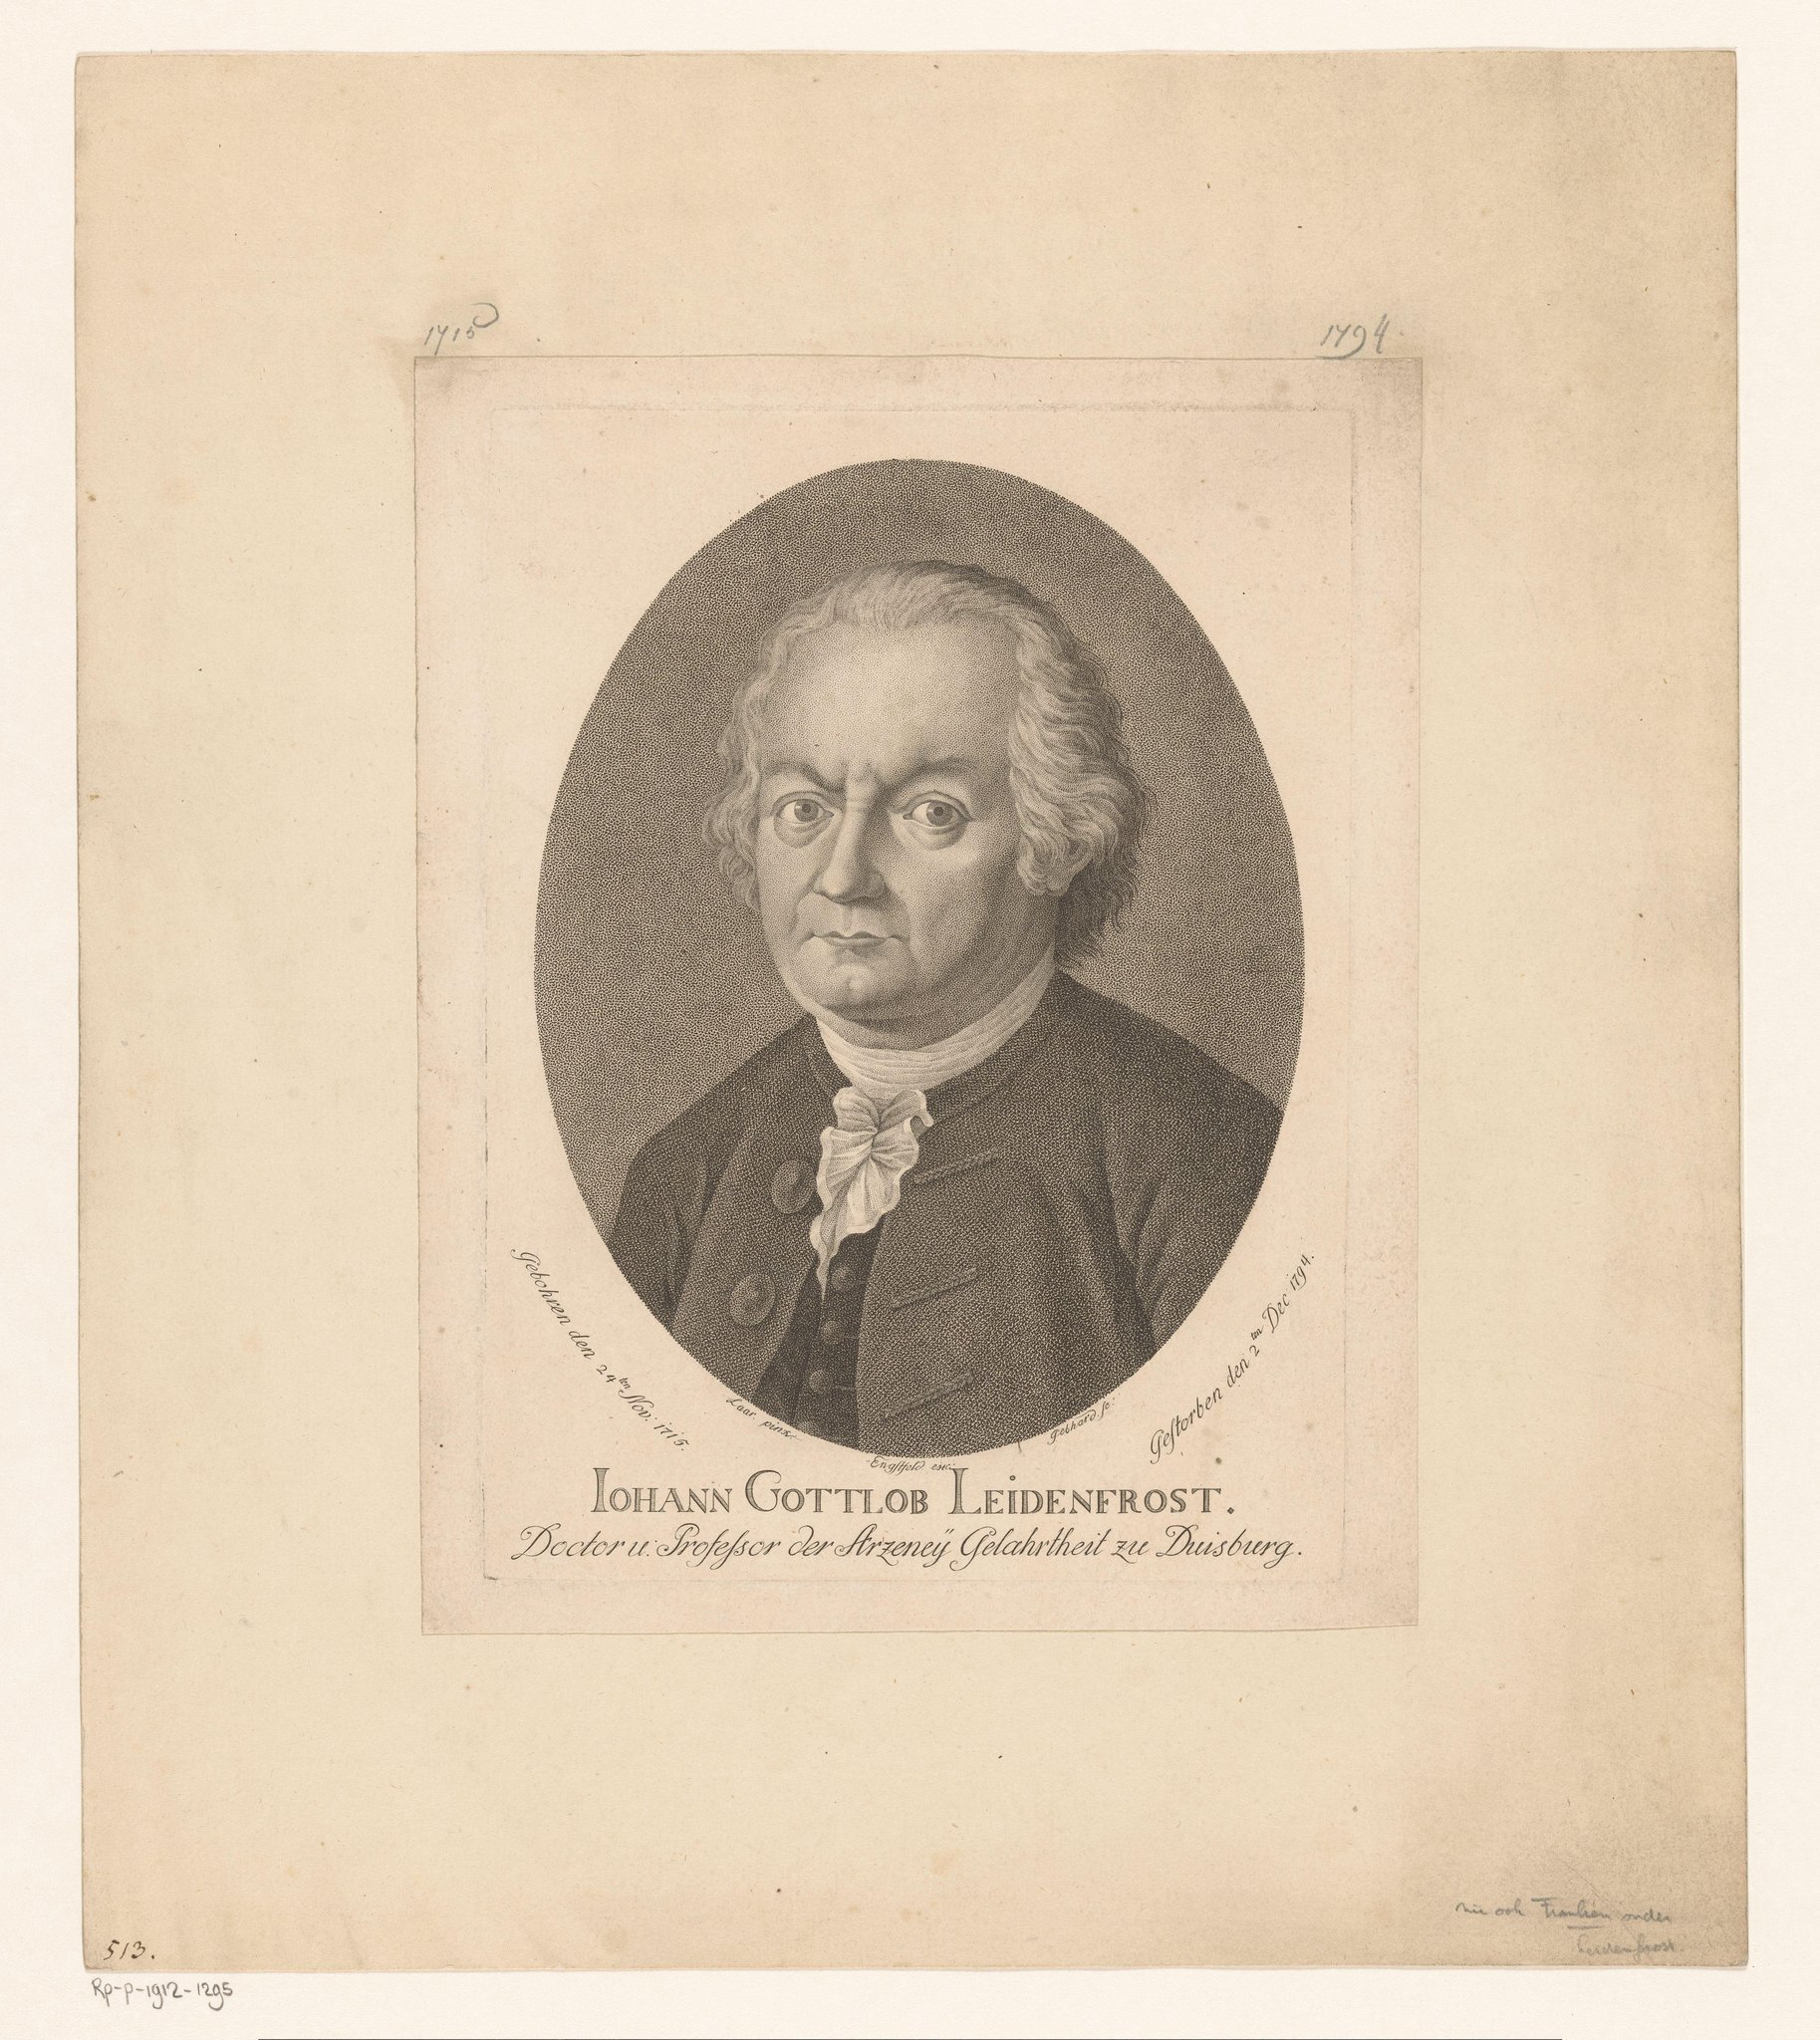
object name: print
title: Portret van Johann Gottlob Leidenfrost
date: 1785-1794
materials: paper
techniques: etching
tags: historical persons, physician, doctor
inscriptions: collector's mark: Lugt 2228